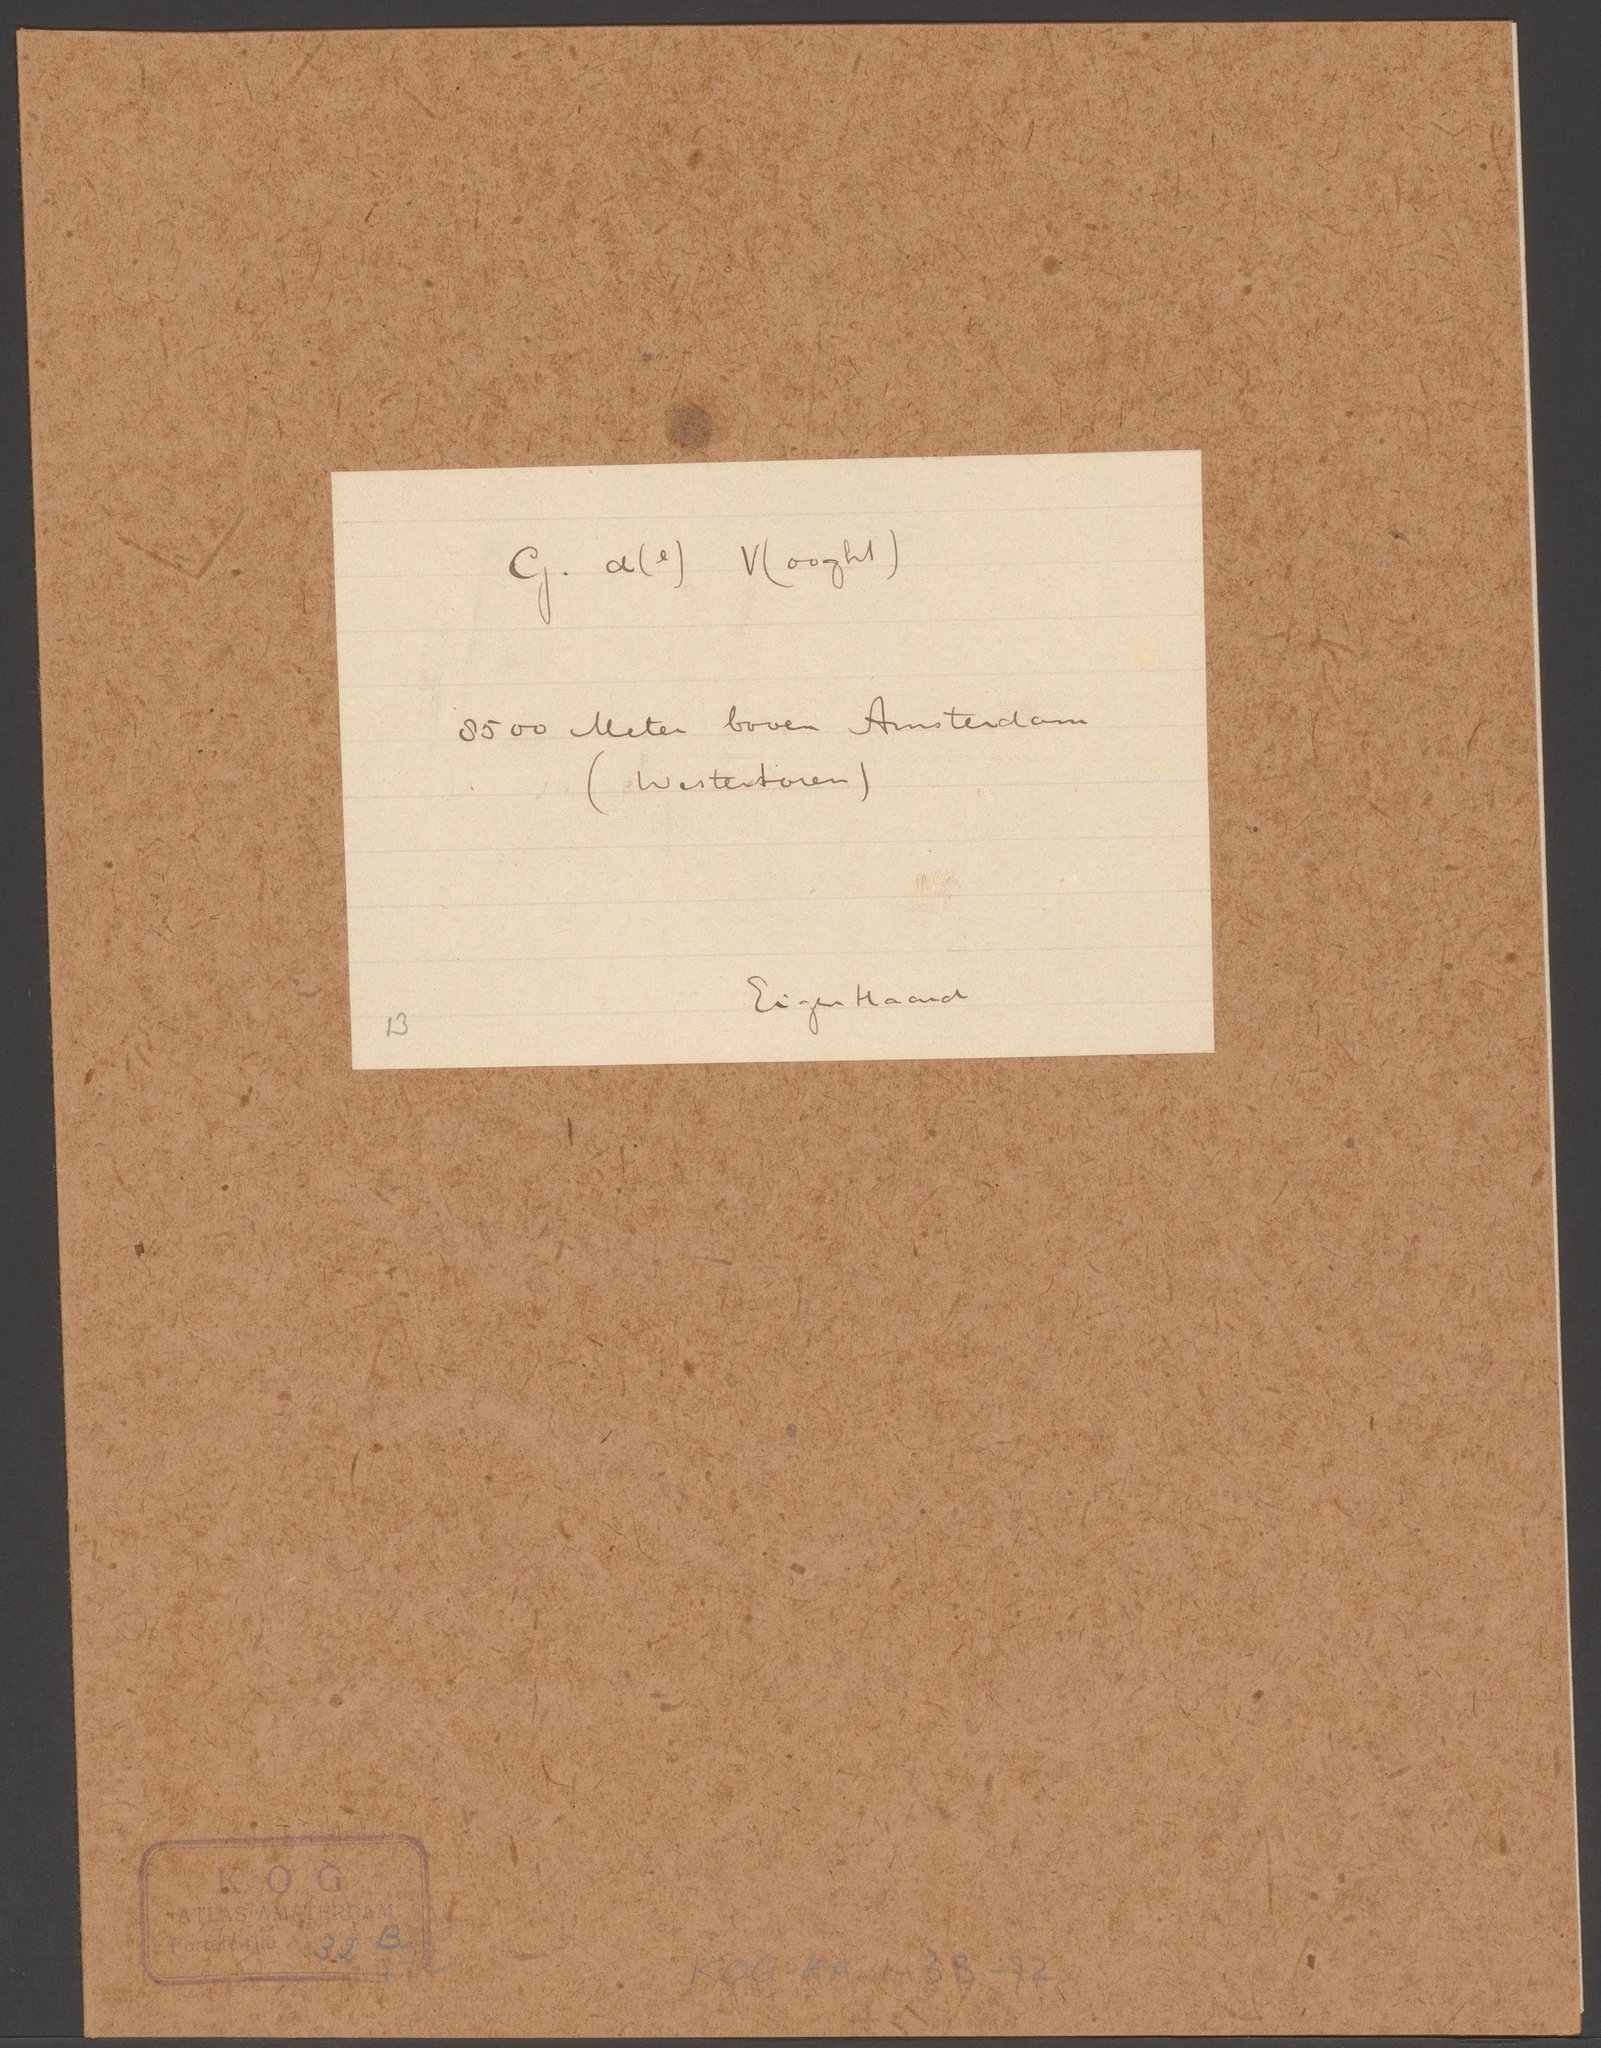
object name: photomechanical print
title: 8500 Meter boven Amsterdam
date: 1907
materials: paper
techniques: letterpress printing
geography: amsterdam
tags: flying mammals: bat, city-view in general; 'veduta', exploration, expedition, voyage of discovery, parts of church exterior and annexes: tower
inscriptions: collector's mark: Lugt 1641b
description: Object bestaat uit drie bladen, in een bruine omslag geplakt. Fotomechanische afdrukken op pagina 699-704. Onderwerpsrubriek binnen de Atlas Amsterdam: Kerkwezen: Hervormde Gemeente: Herinneringen aan hervormde predikanten.